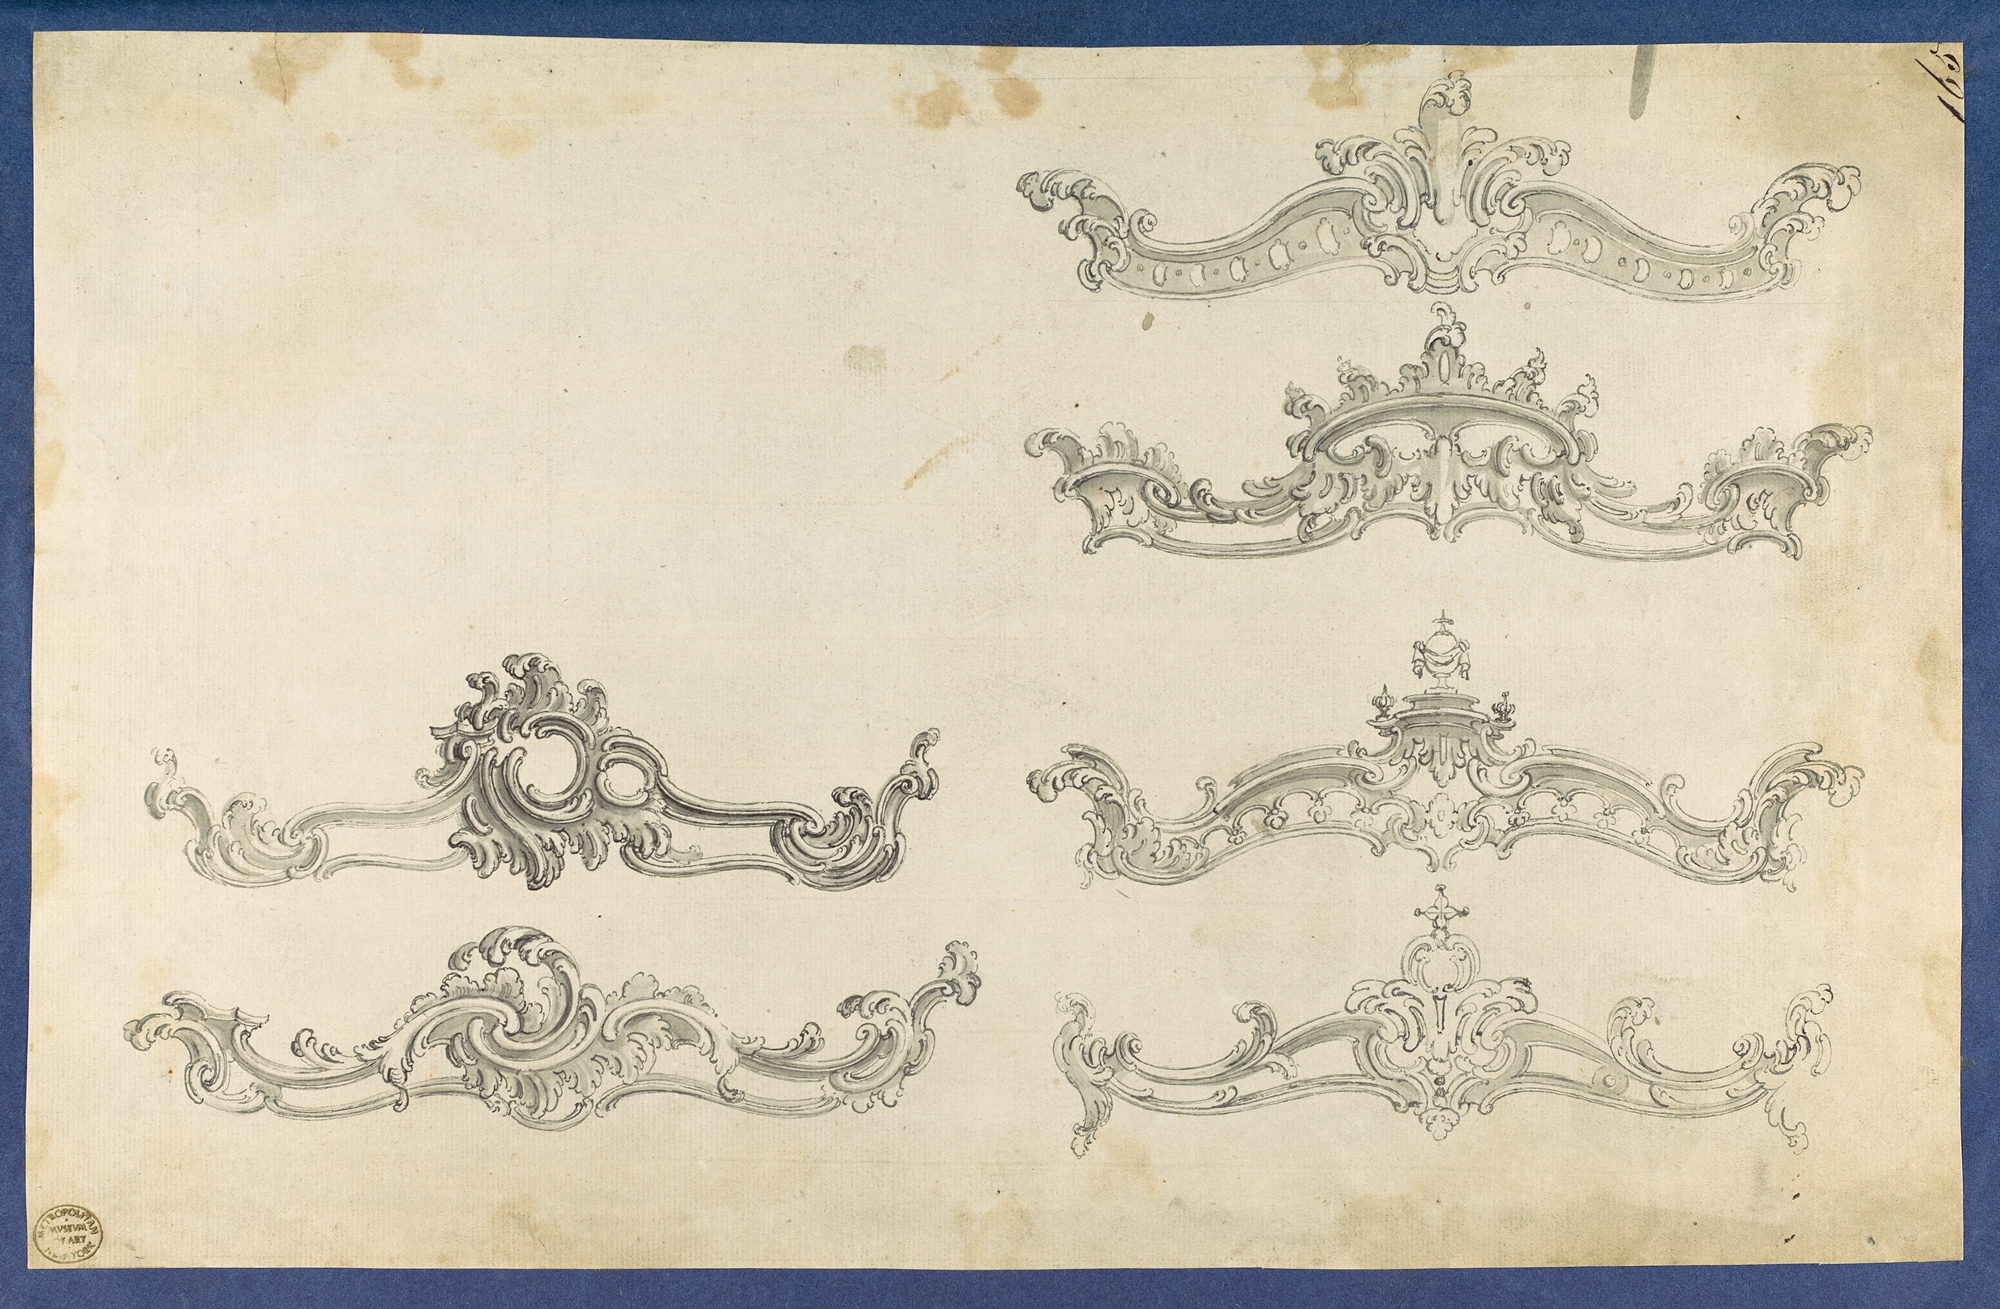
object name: drawing ornament architecture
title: Cornices, in Chippendale Drawings, Vol. I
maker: thomas chippendale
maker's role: artist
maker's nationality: british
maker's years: 1718-1779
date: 1753-1762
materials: ink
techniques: wash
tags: ornament